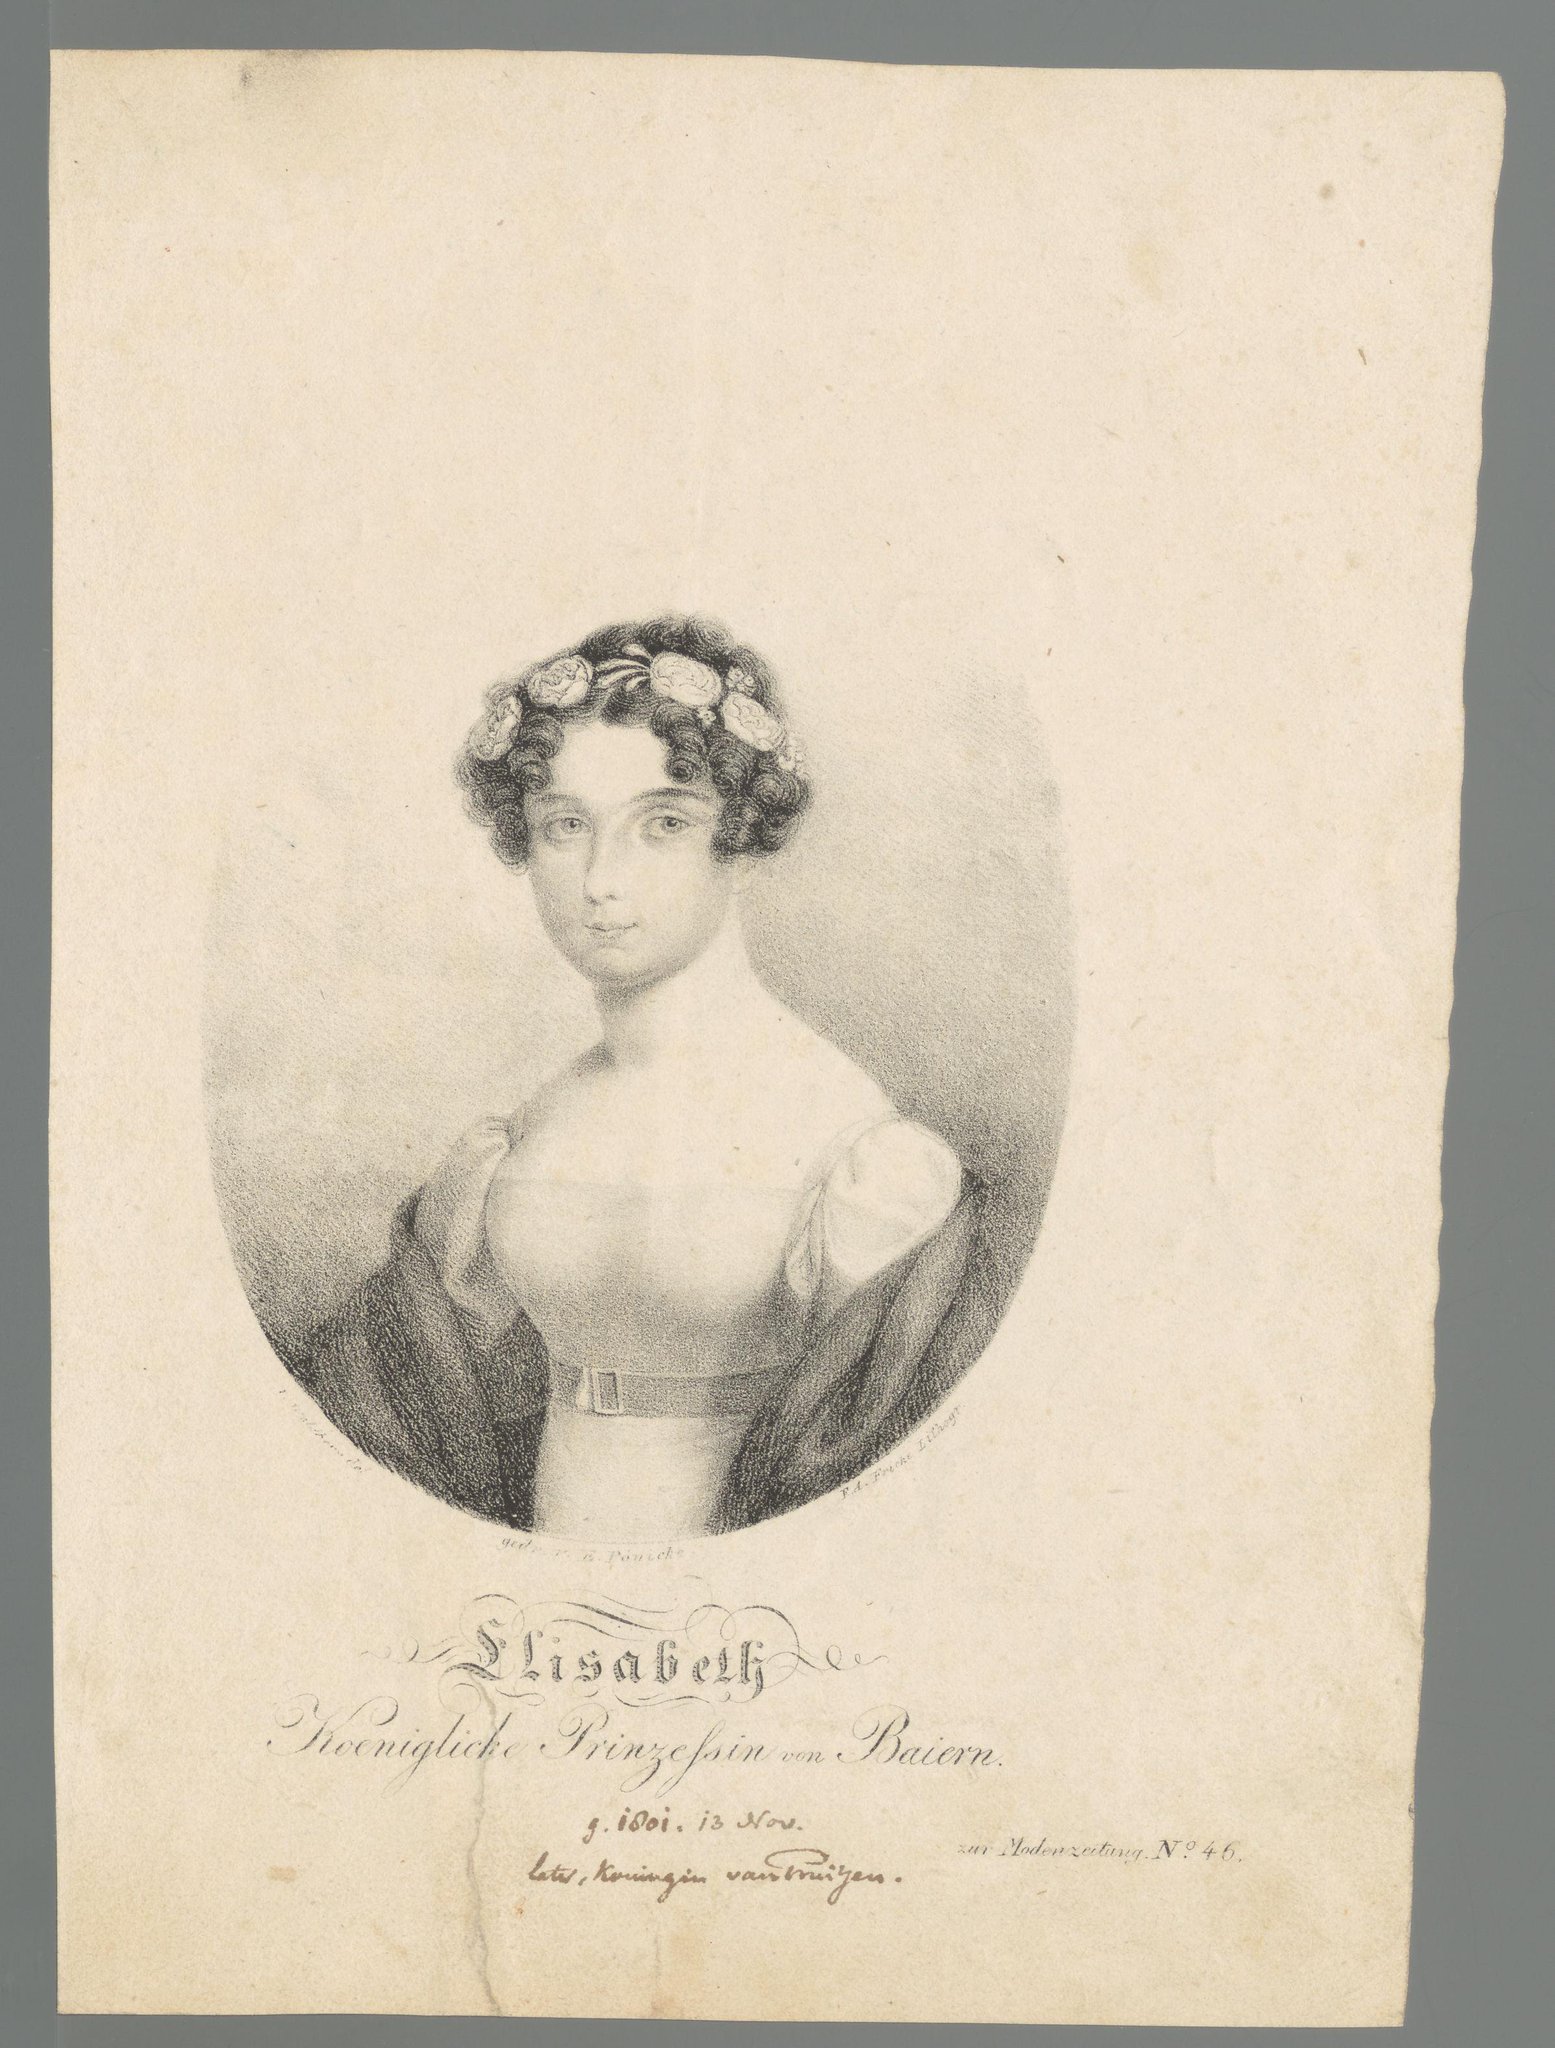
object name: print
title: Elisabeth, Koeniglicke Prinzessin von Baiern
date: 1794-1858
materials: paper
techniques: lithograph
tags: adult woman, historical persons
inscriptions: mark: ‘Wald[horn].’, collector's mark: Lugt 2228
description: Prent uit een onbekende uitgave van 'zur Modenzeitung', nr. 46.